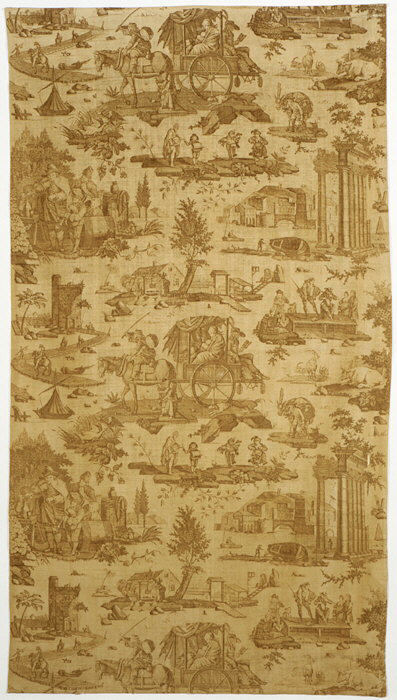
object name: piece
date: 1701-1800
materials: cotton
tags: human figures,animals,horses,musicians,carts